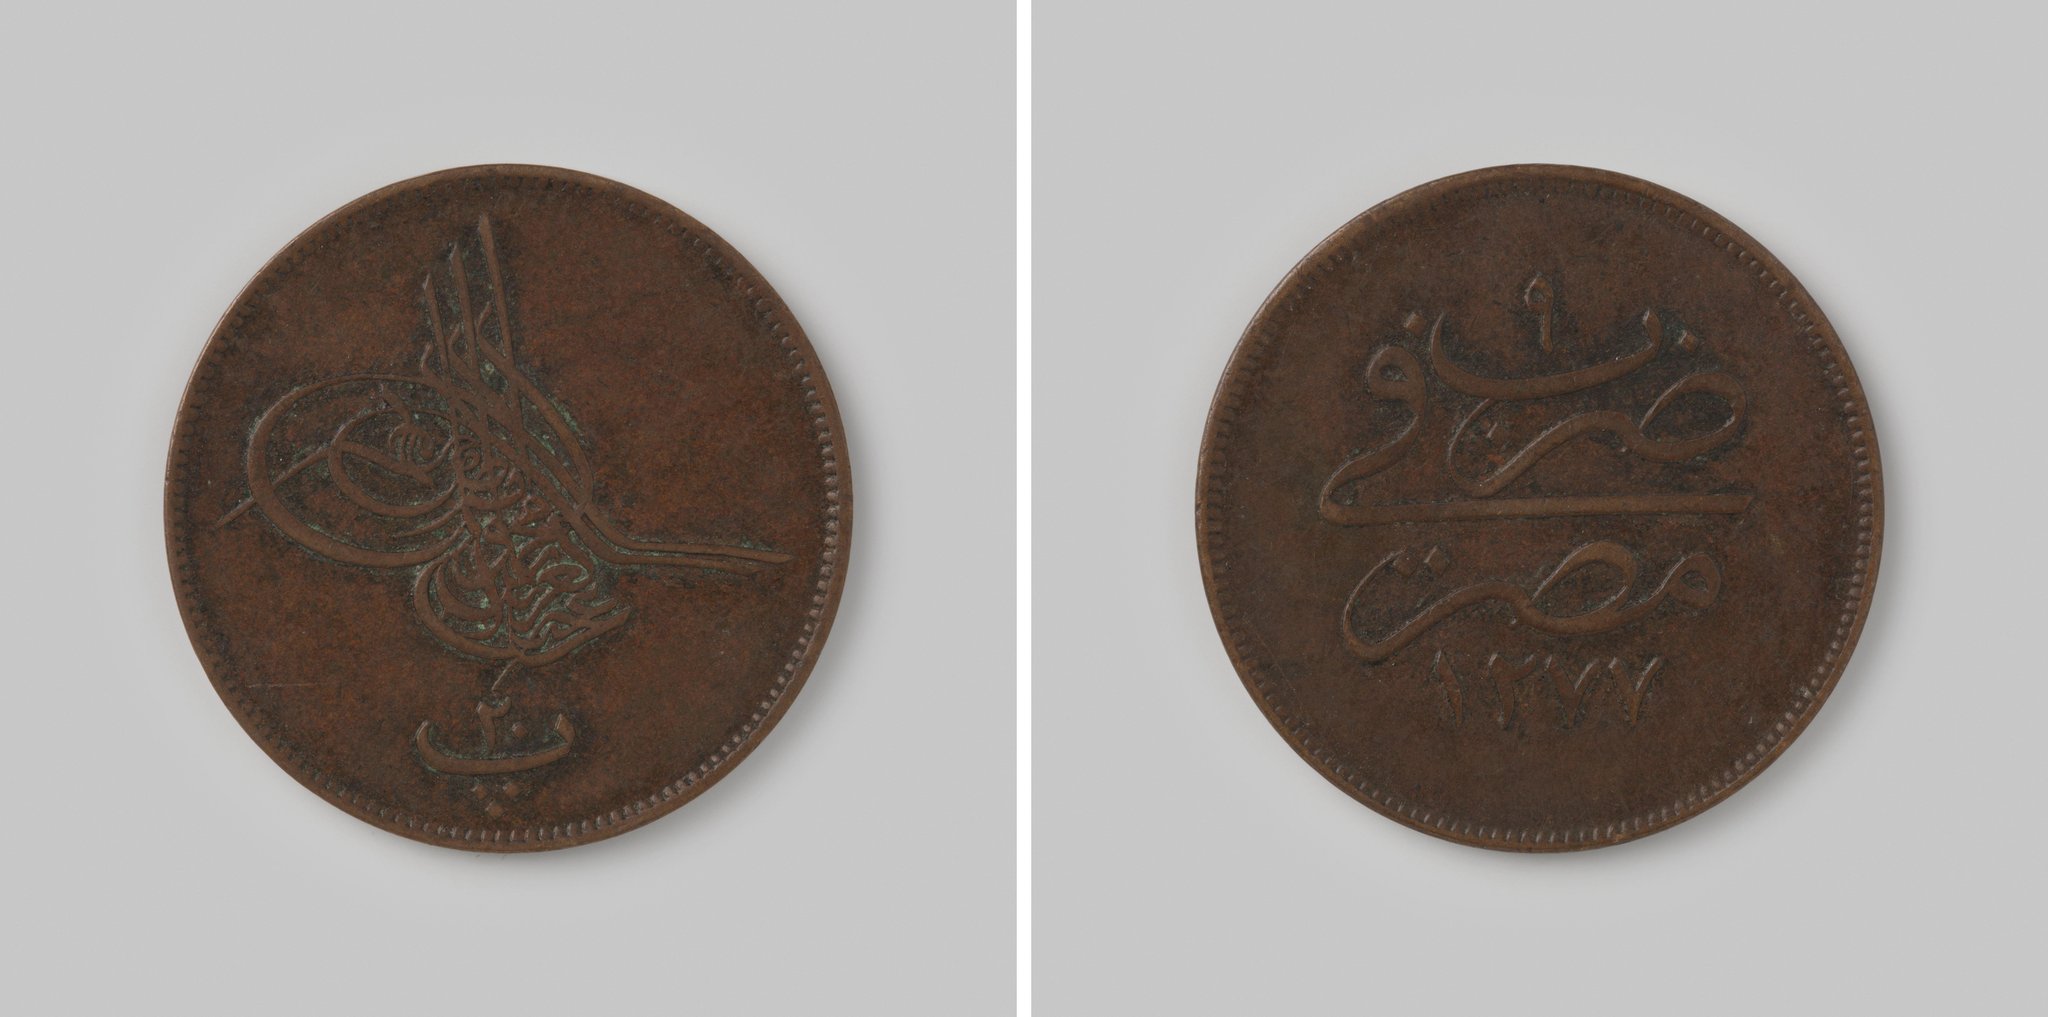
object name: coin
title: 20 para uit Egypte van de Ottomaanse sultan Abdul-Aziz,1285 [=1869]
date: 1869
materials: bronze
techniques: striking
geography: cairo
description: Bronzen munt. Voorzijde: tughra. Daaronder waarde-aanduiding: 20 para. Keerzijde: drieregelig opschrift in Arabische letters: zuriba fi Misr [=Egypte, Caïro]. Daarboven cijfer: 9 [=regeringsjaar] en daaronder jaar van aantreden:1277.